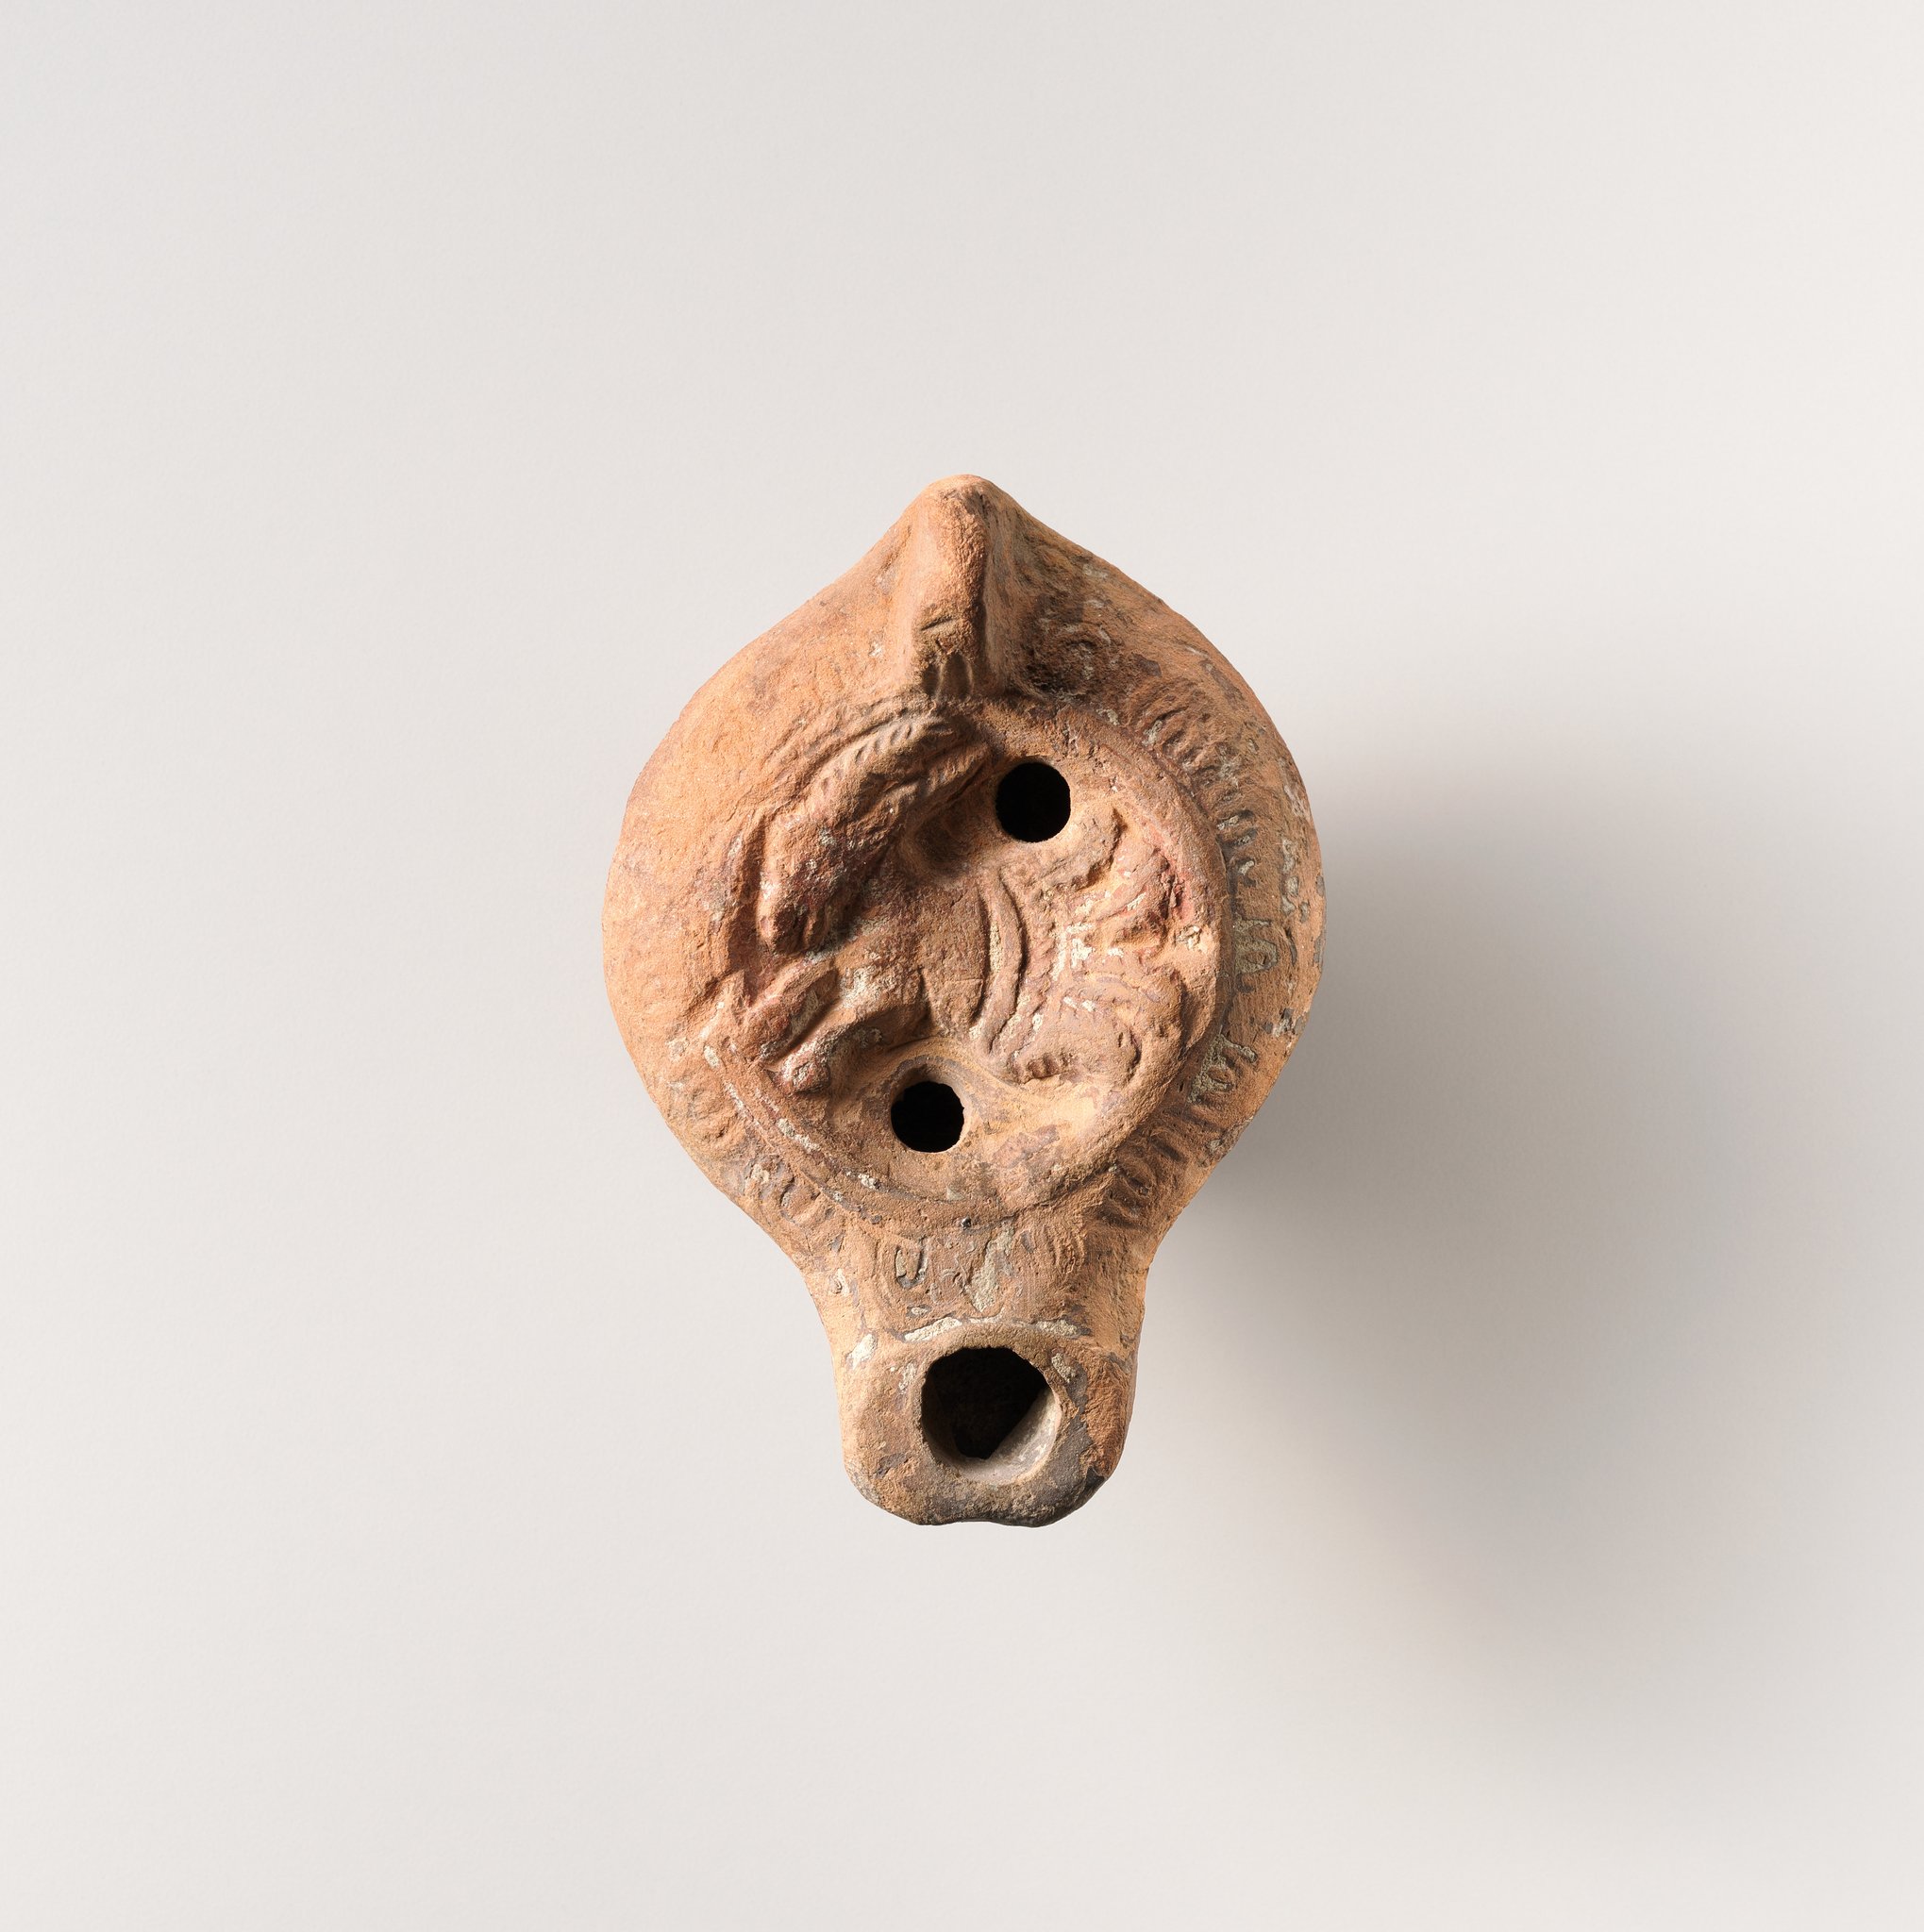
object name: lamp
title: Terracotta oil lamp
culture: roman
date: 501-600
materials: terracotta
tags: goats